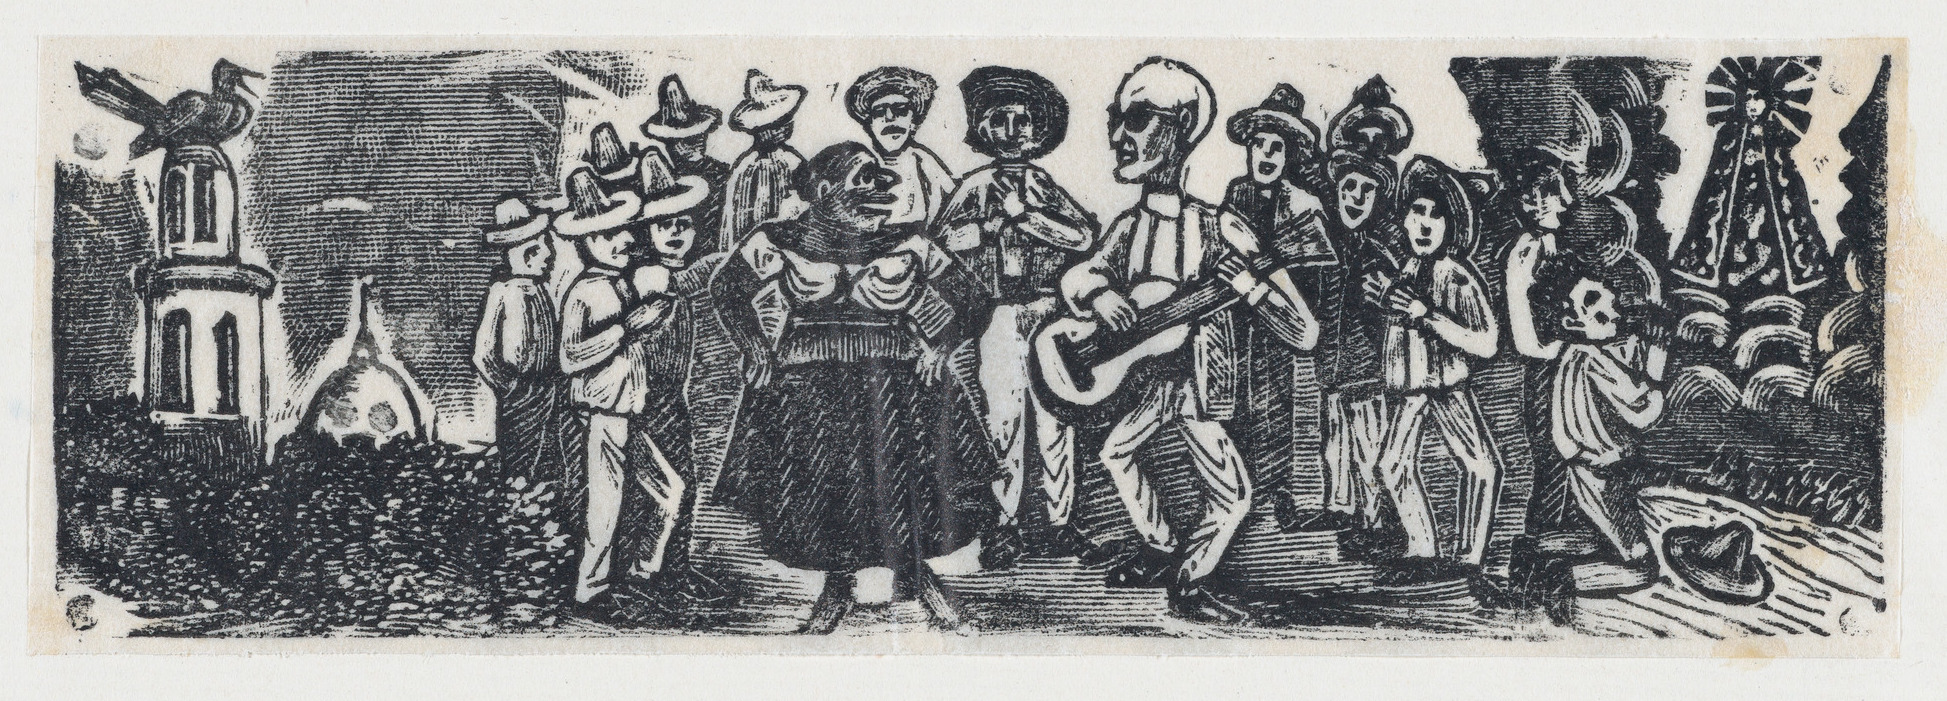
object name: print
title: A man playing a guitar serenading a woman, figures surround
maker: josé guadalupe posada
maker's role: artist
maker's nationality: mexican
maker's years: 1852-1913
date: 1896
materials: metal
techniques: engraving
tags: men,women,guitars